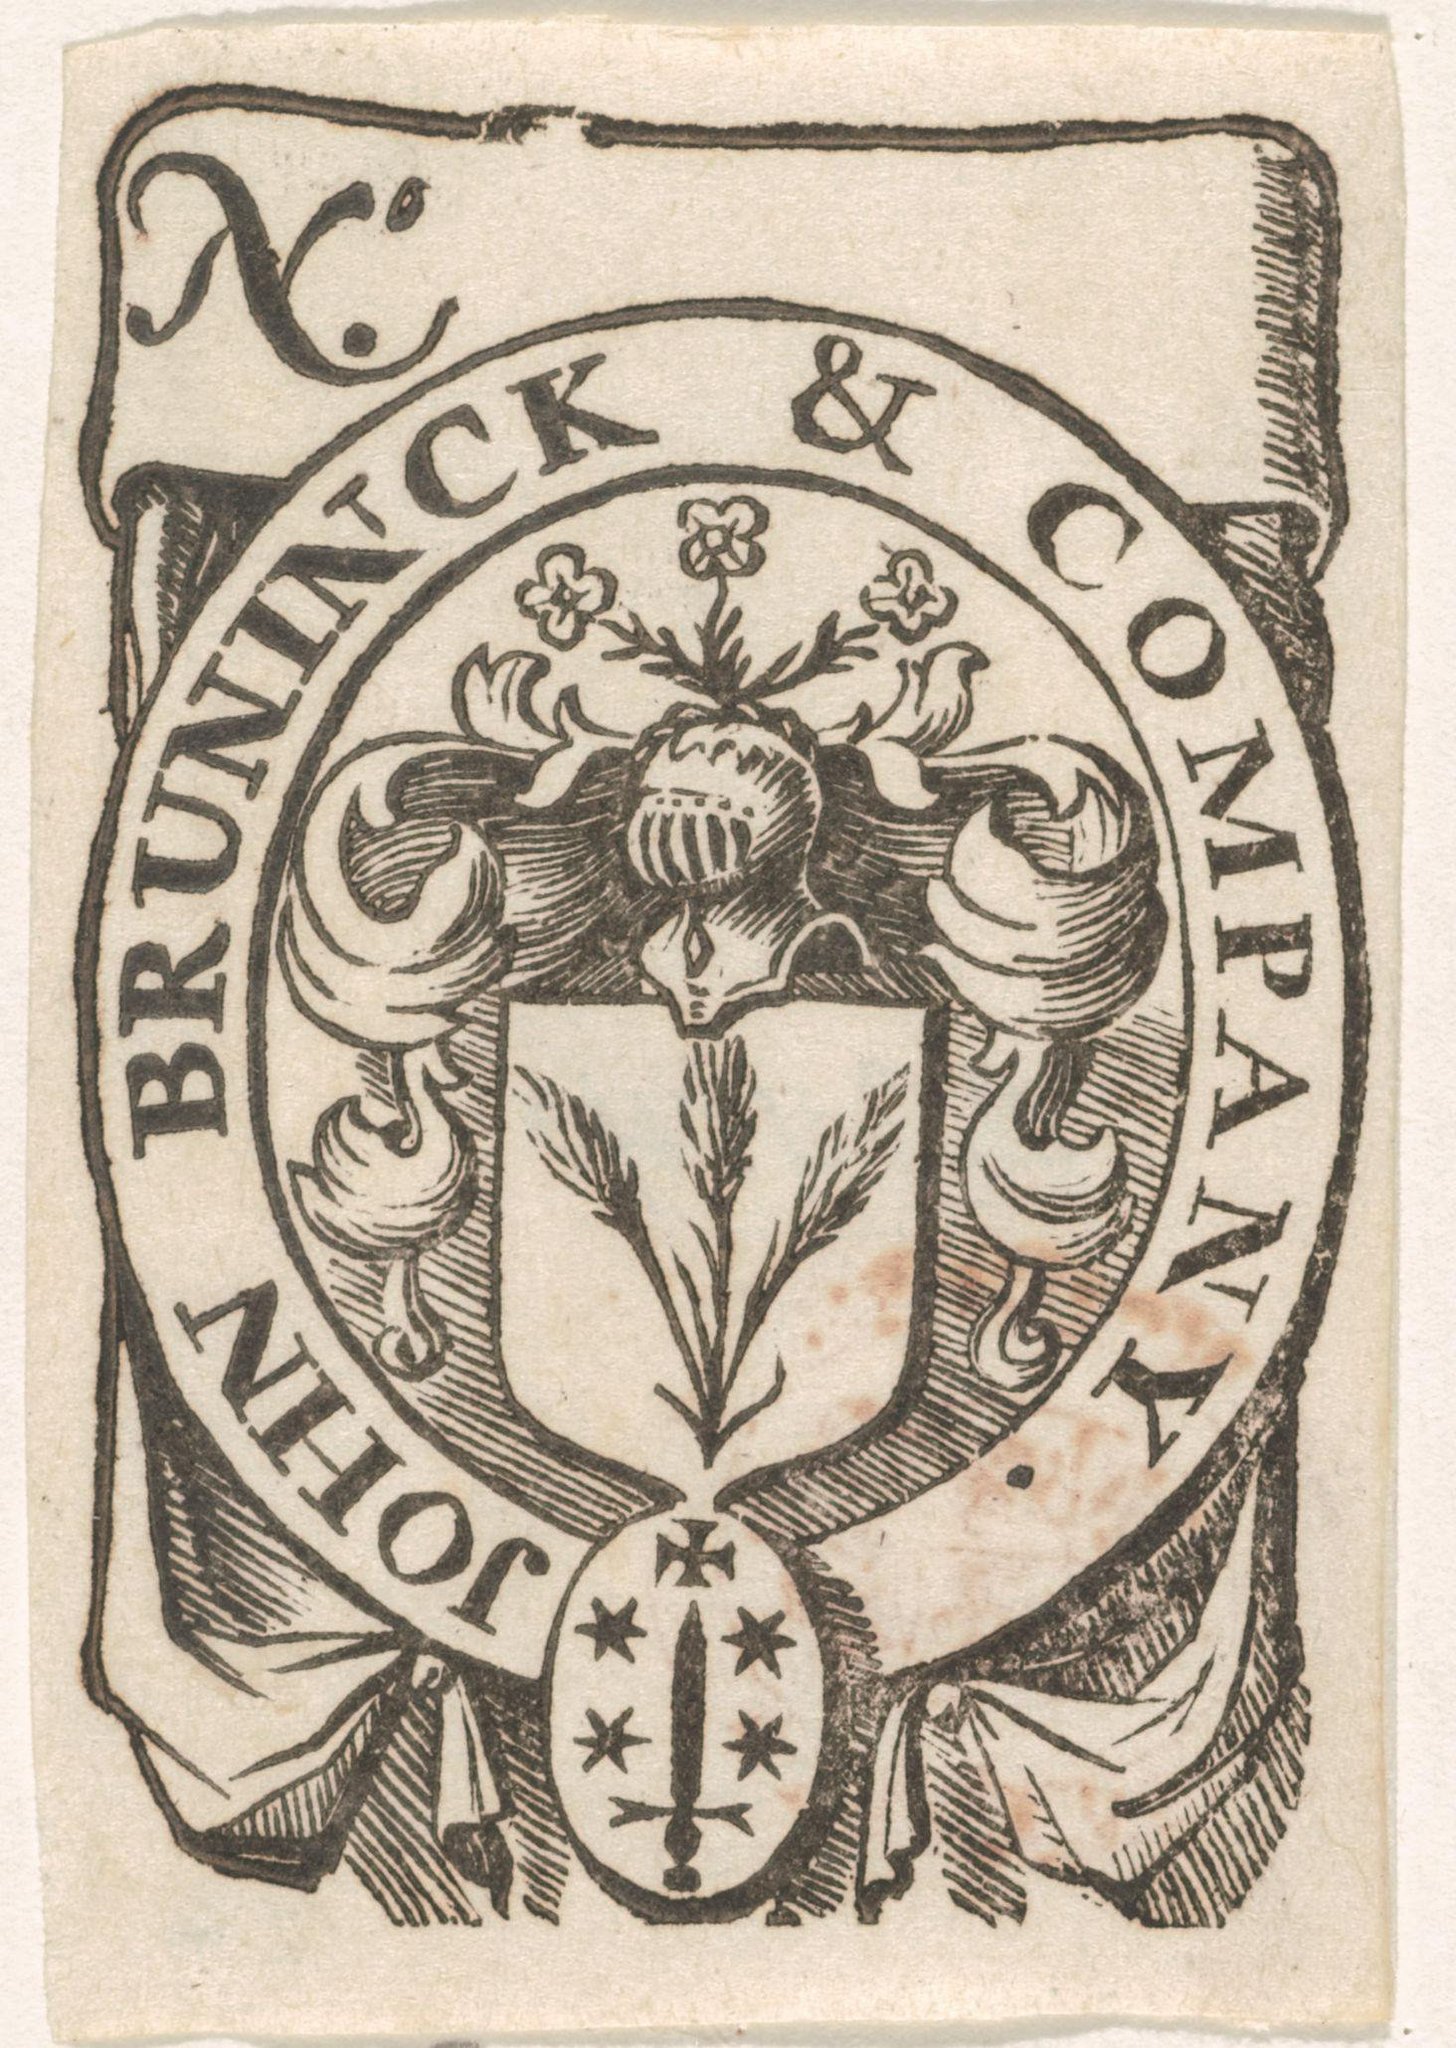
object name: handelsetiket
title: Handelsetiket van John Brunick & company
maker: isaac vincentsz. van der vinne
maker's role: draughtsman, print maker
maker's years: 1665-1740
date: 1681-1740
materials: paper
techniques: woodcut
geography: haarlem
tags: coat of arms (as symbol of the state, etc.), coat of arms (as symbol of the state, etc.) (+ city; municipal), ear of corn, vignette, haarlem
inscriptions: collector's mark: Lugt 240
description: Wapen met drie korenaren in een ovaal met randschrift. Midden onder het wapen van de stad Haarlem.